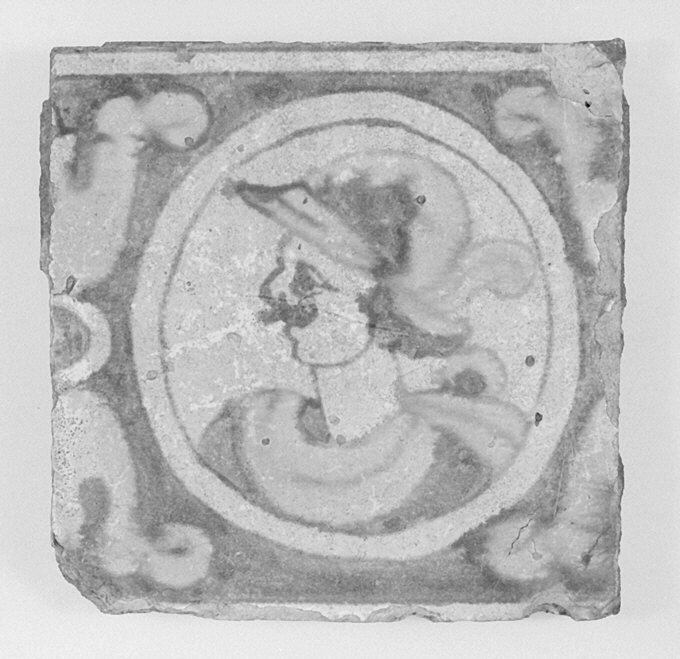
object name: wall tile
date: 1601-1700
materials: earthenware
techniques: glazing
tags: profiles,women